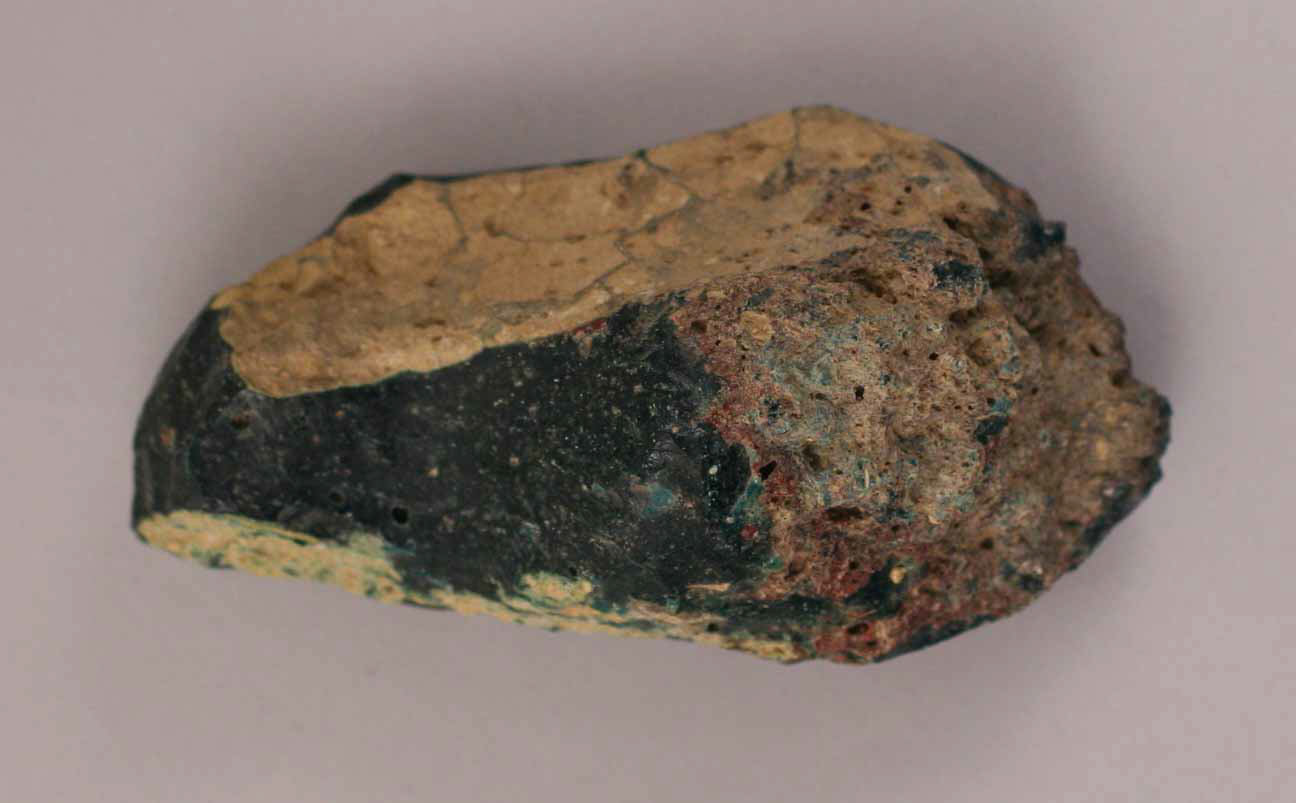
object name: fragment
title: Ceramic Fragment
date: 801-900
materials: glass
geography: iraq